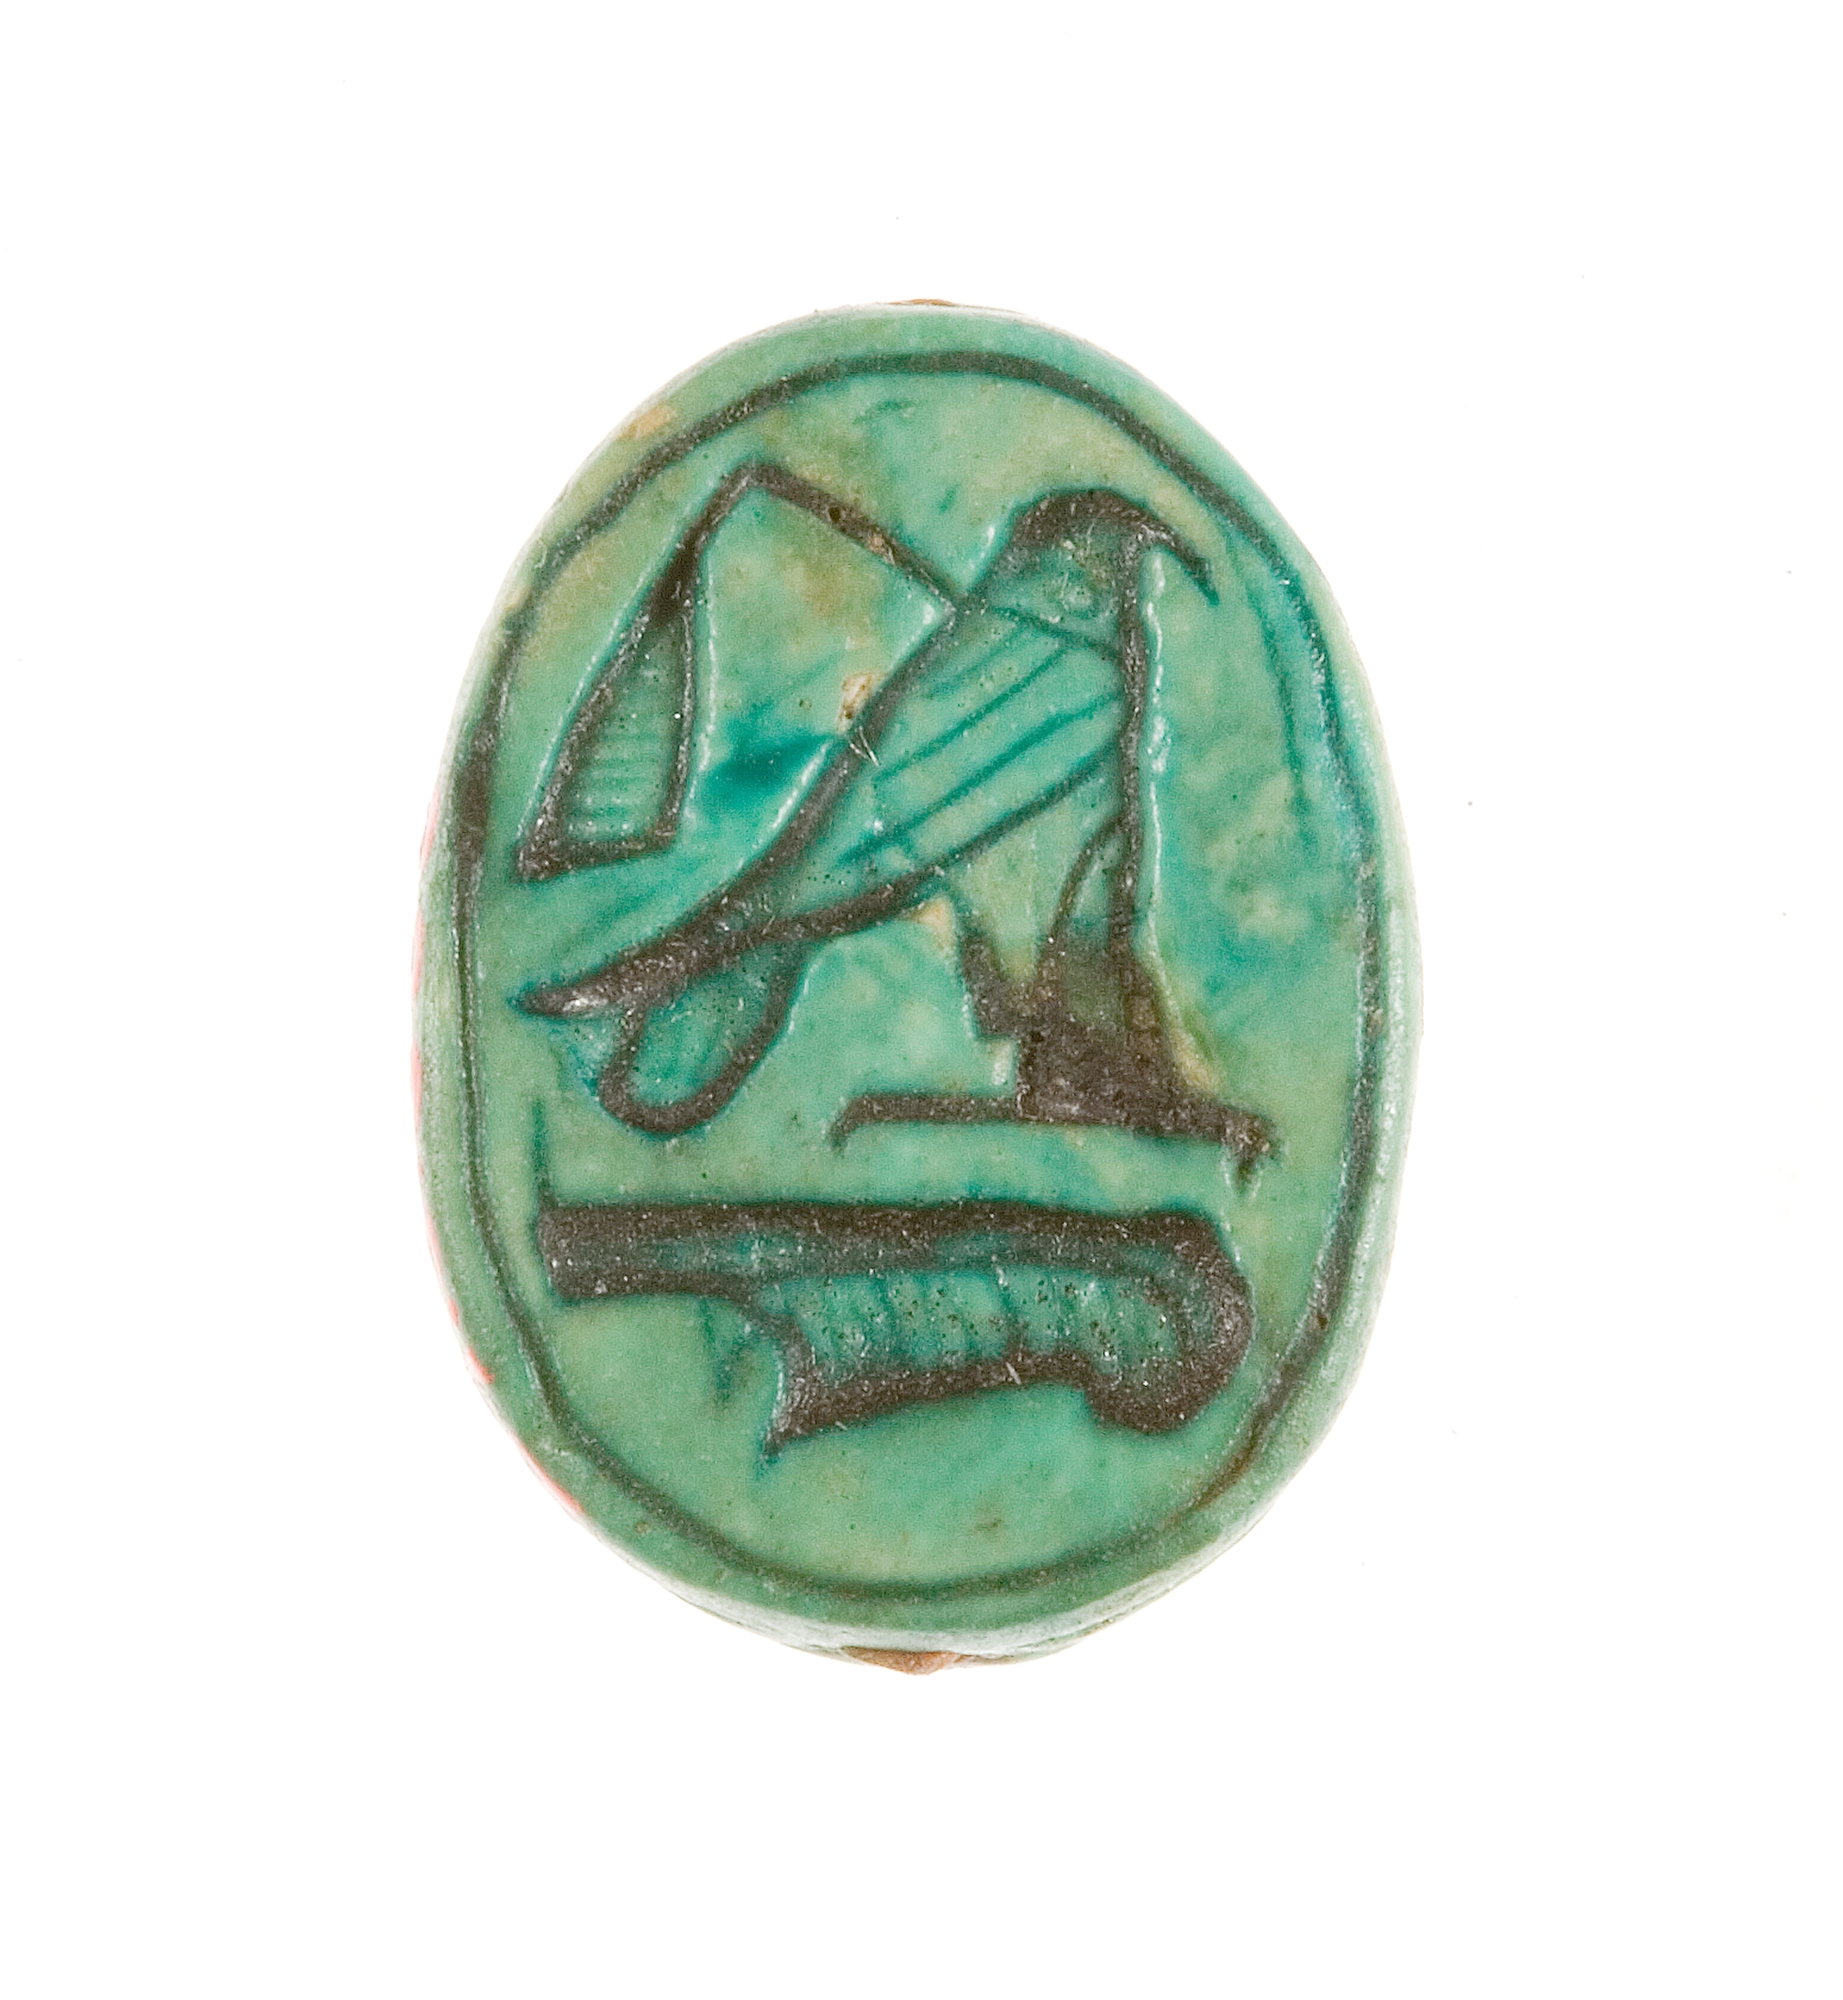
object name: scarab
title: Scarab Inscribed with a Hieroglyphic Motif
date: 1479-1458 BCE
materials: stone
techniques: glazing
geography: egypt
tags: hieroglyphs,scarabs